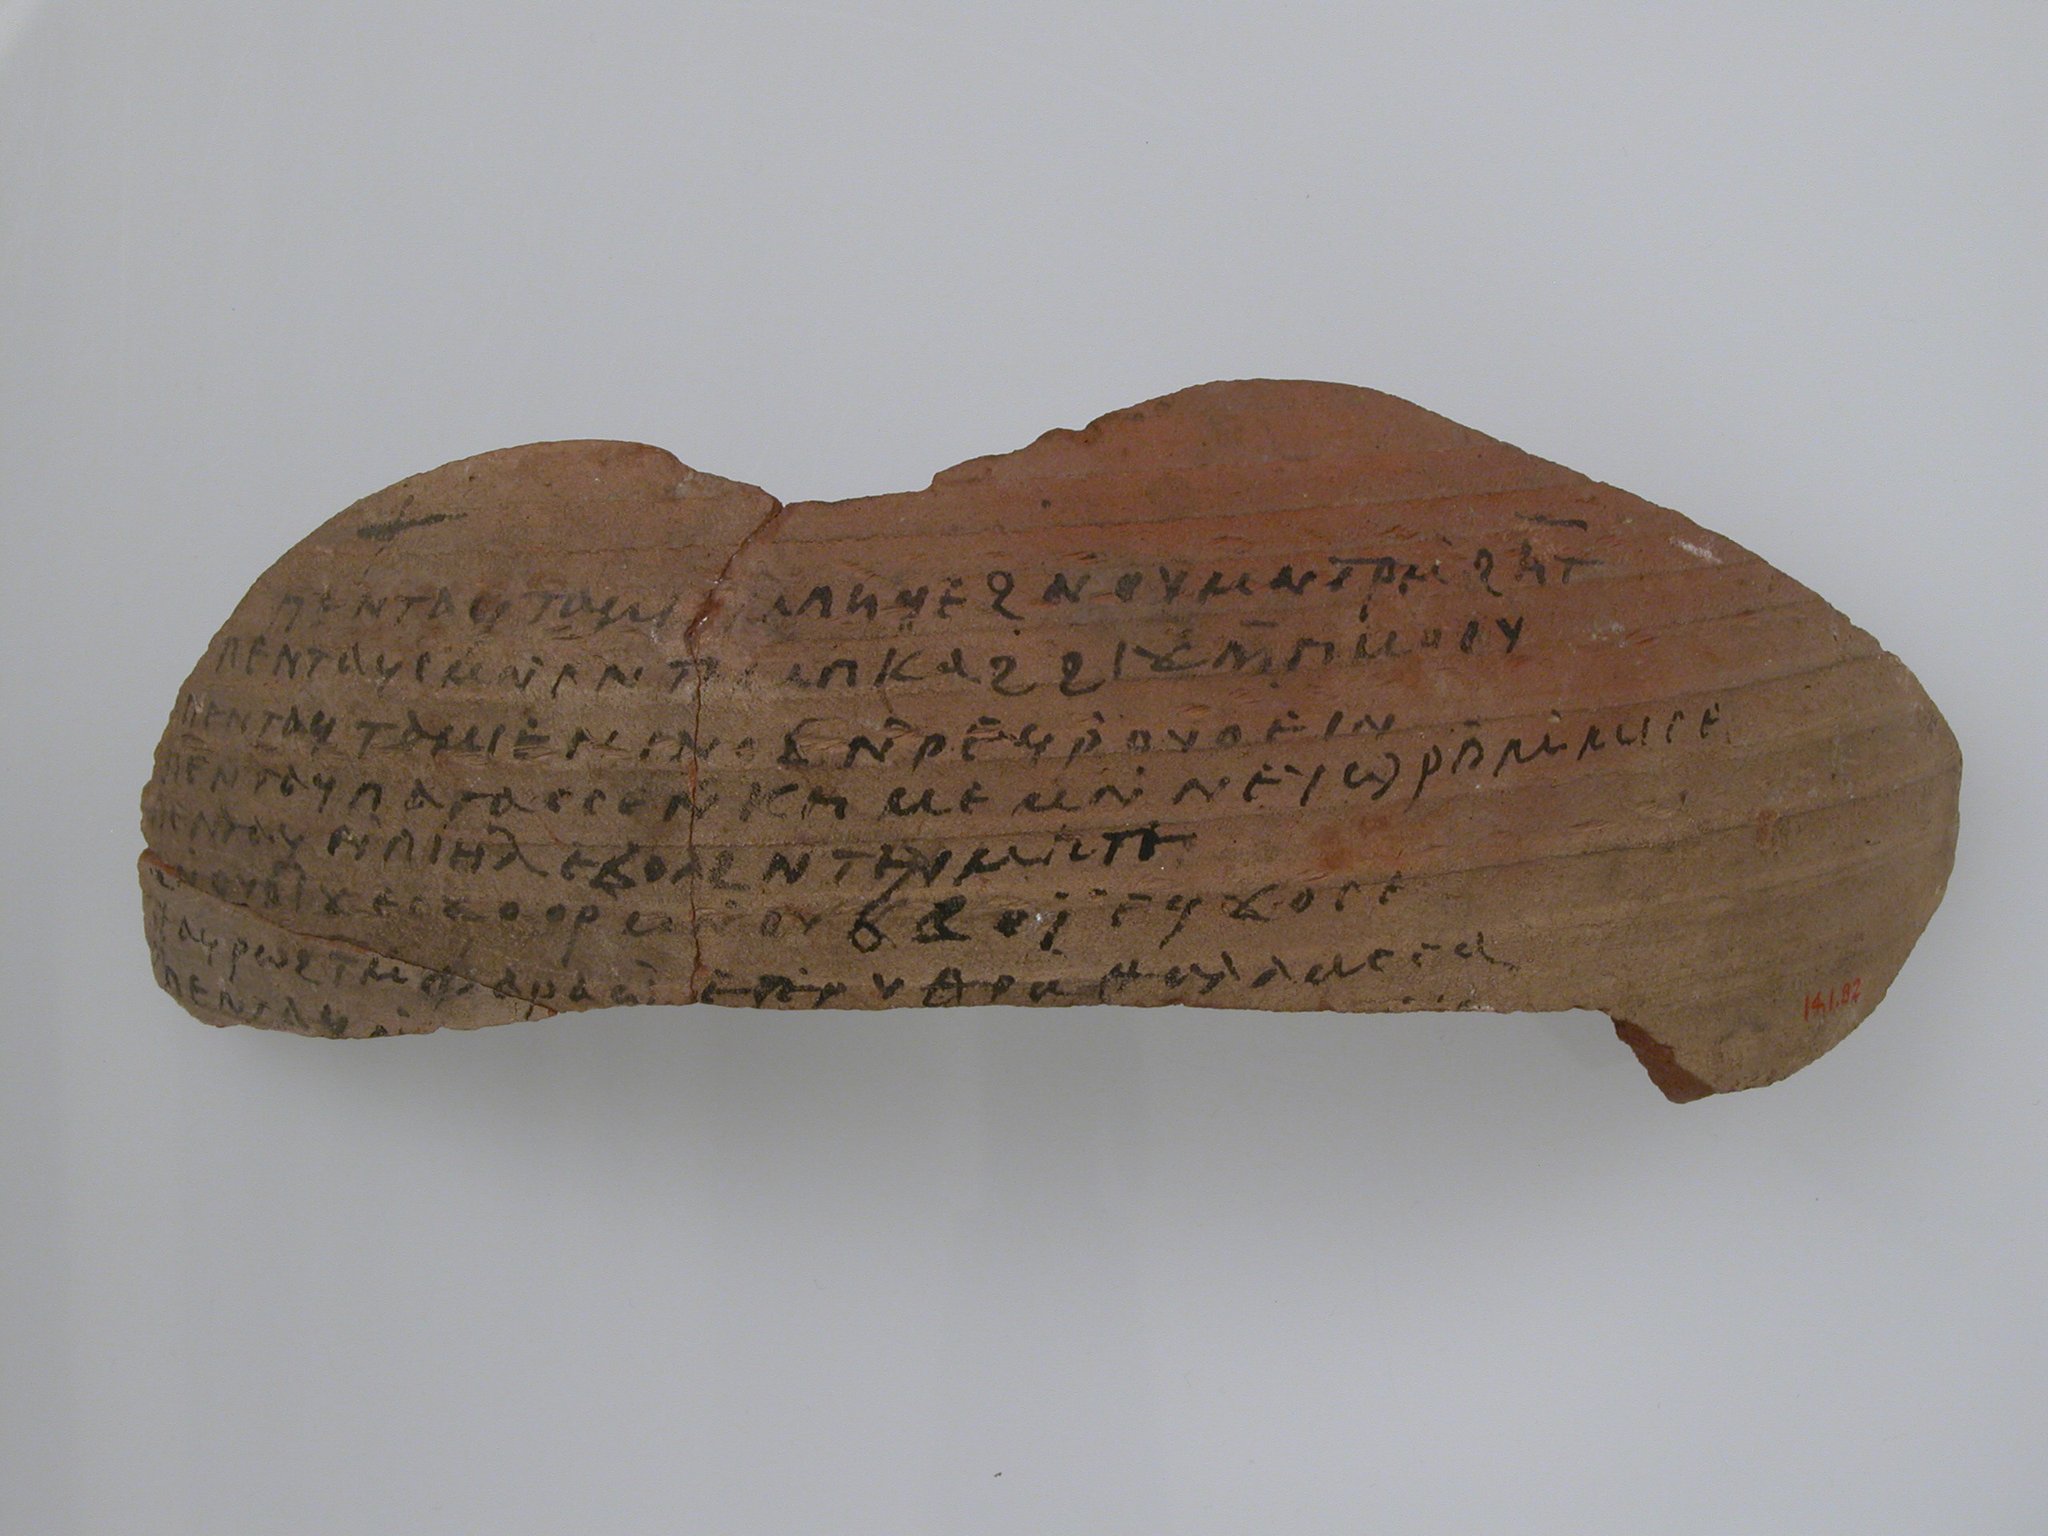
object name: ostrakon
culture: coptic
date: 600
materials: ink, pottery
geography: egypt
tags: coptic,documents